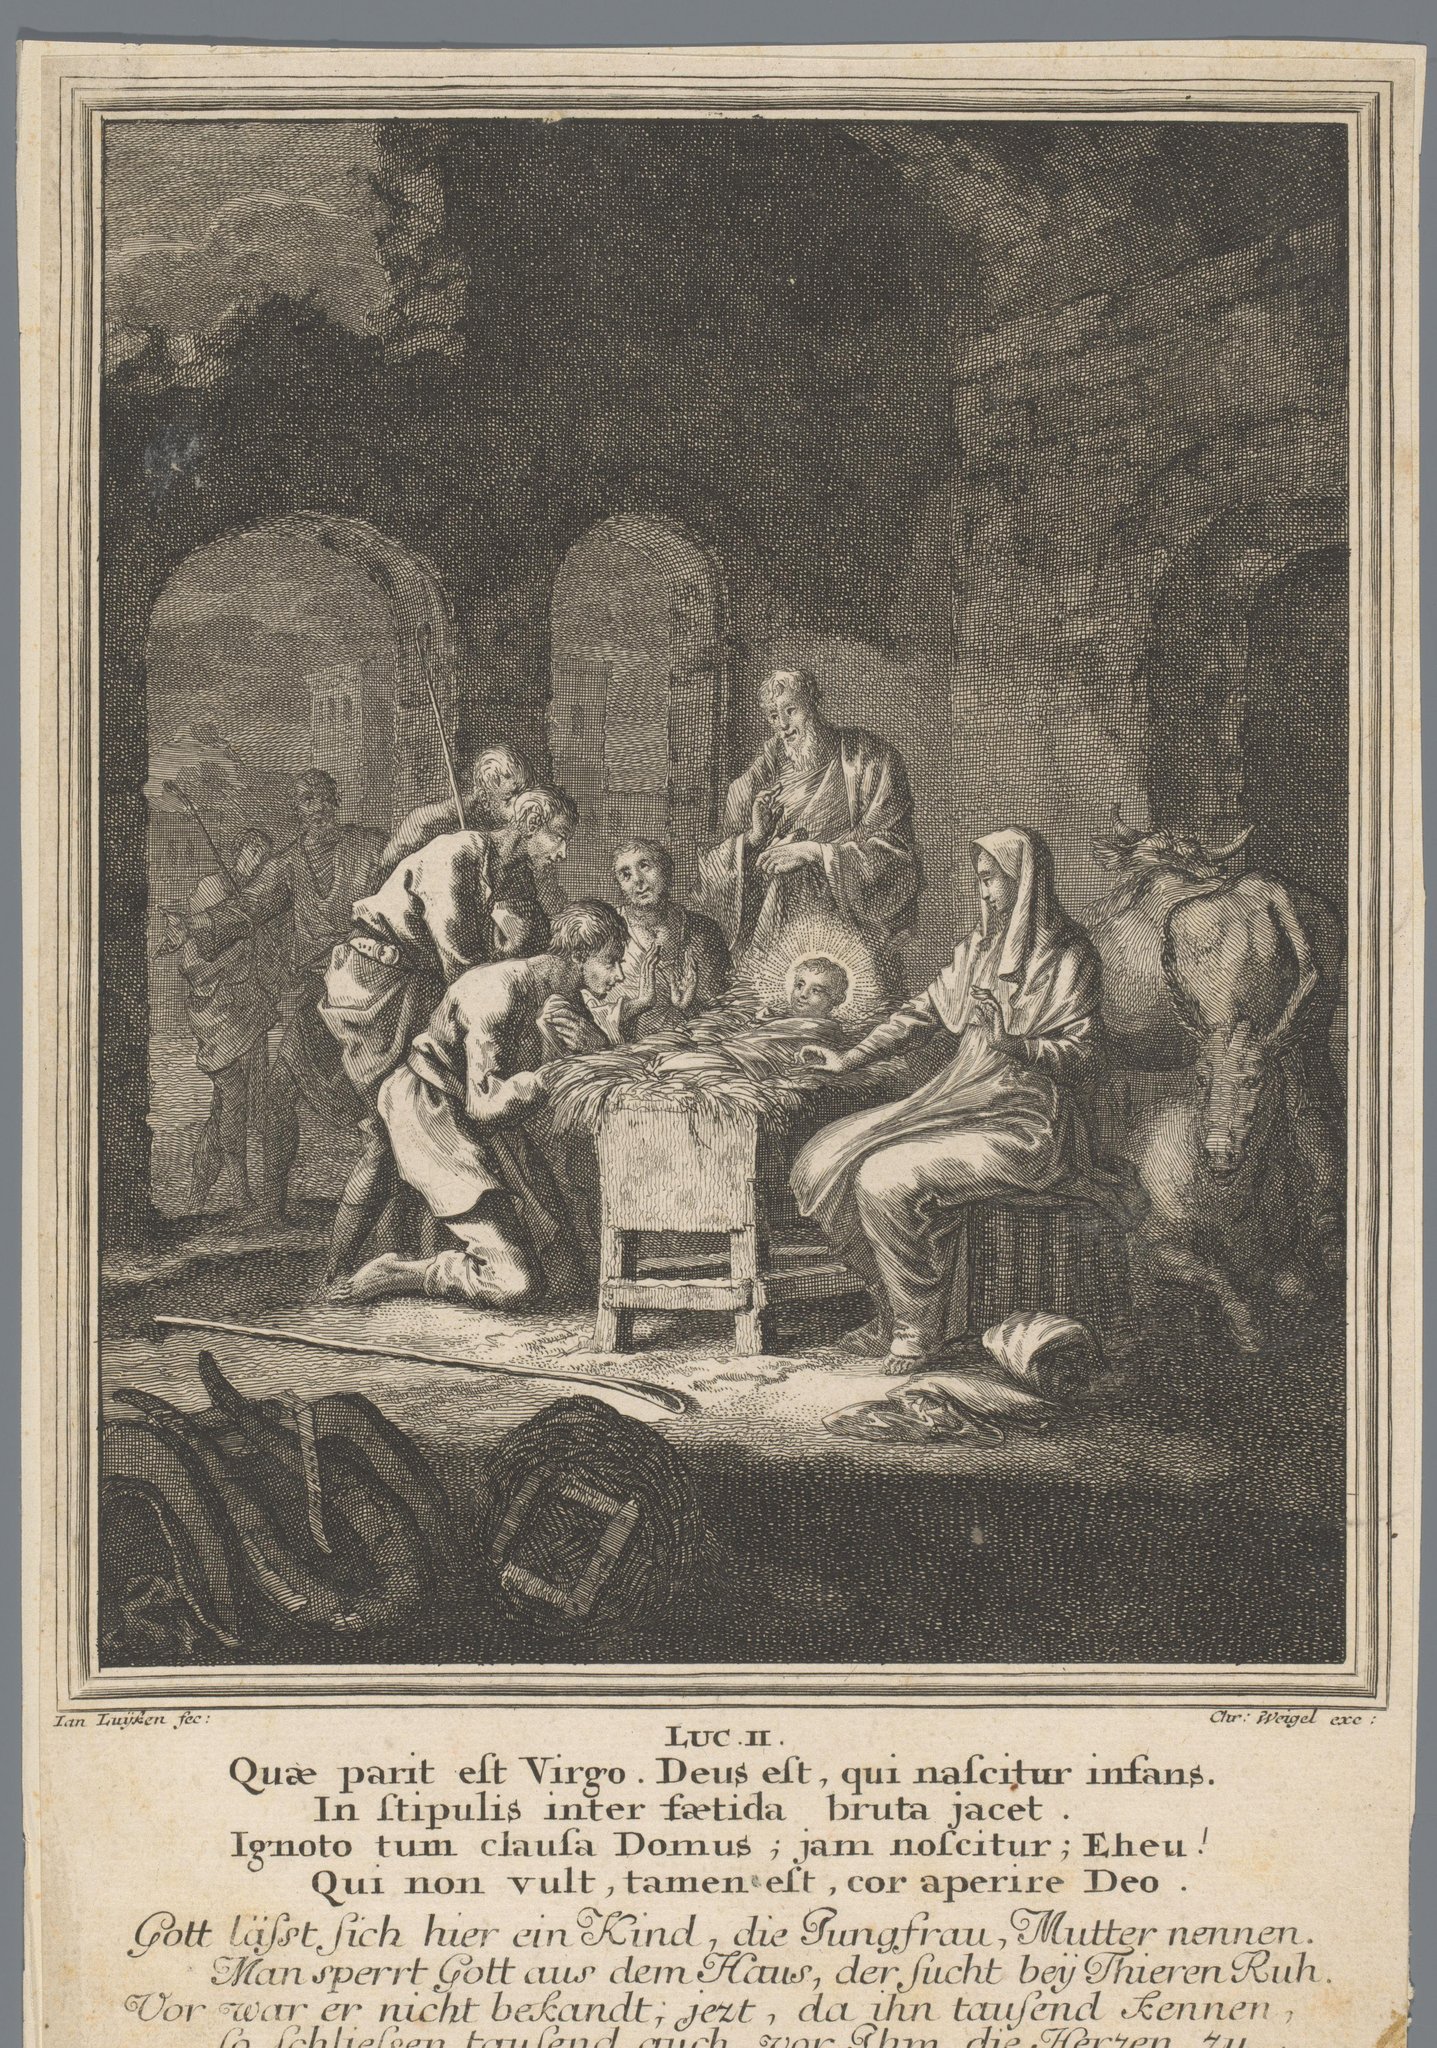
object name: print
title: Aanbidding door de Herders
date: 1659-1712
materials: paper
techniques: etching